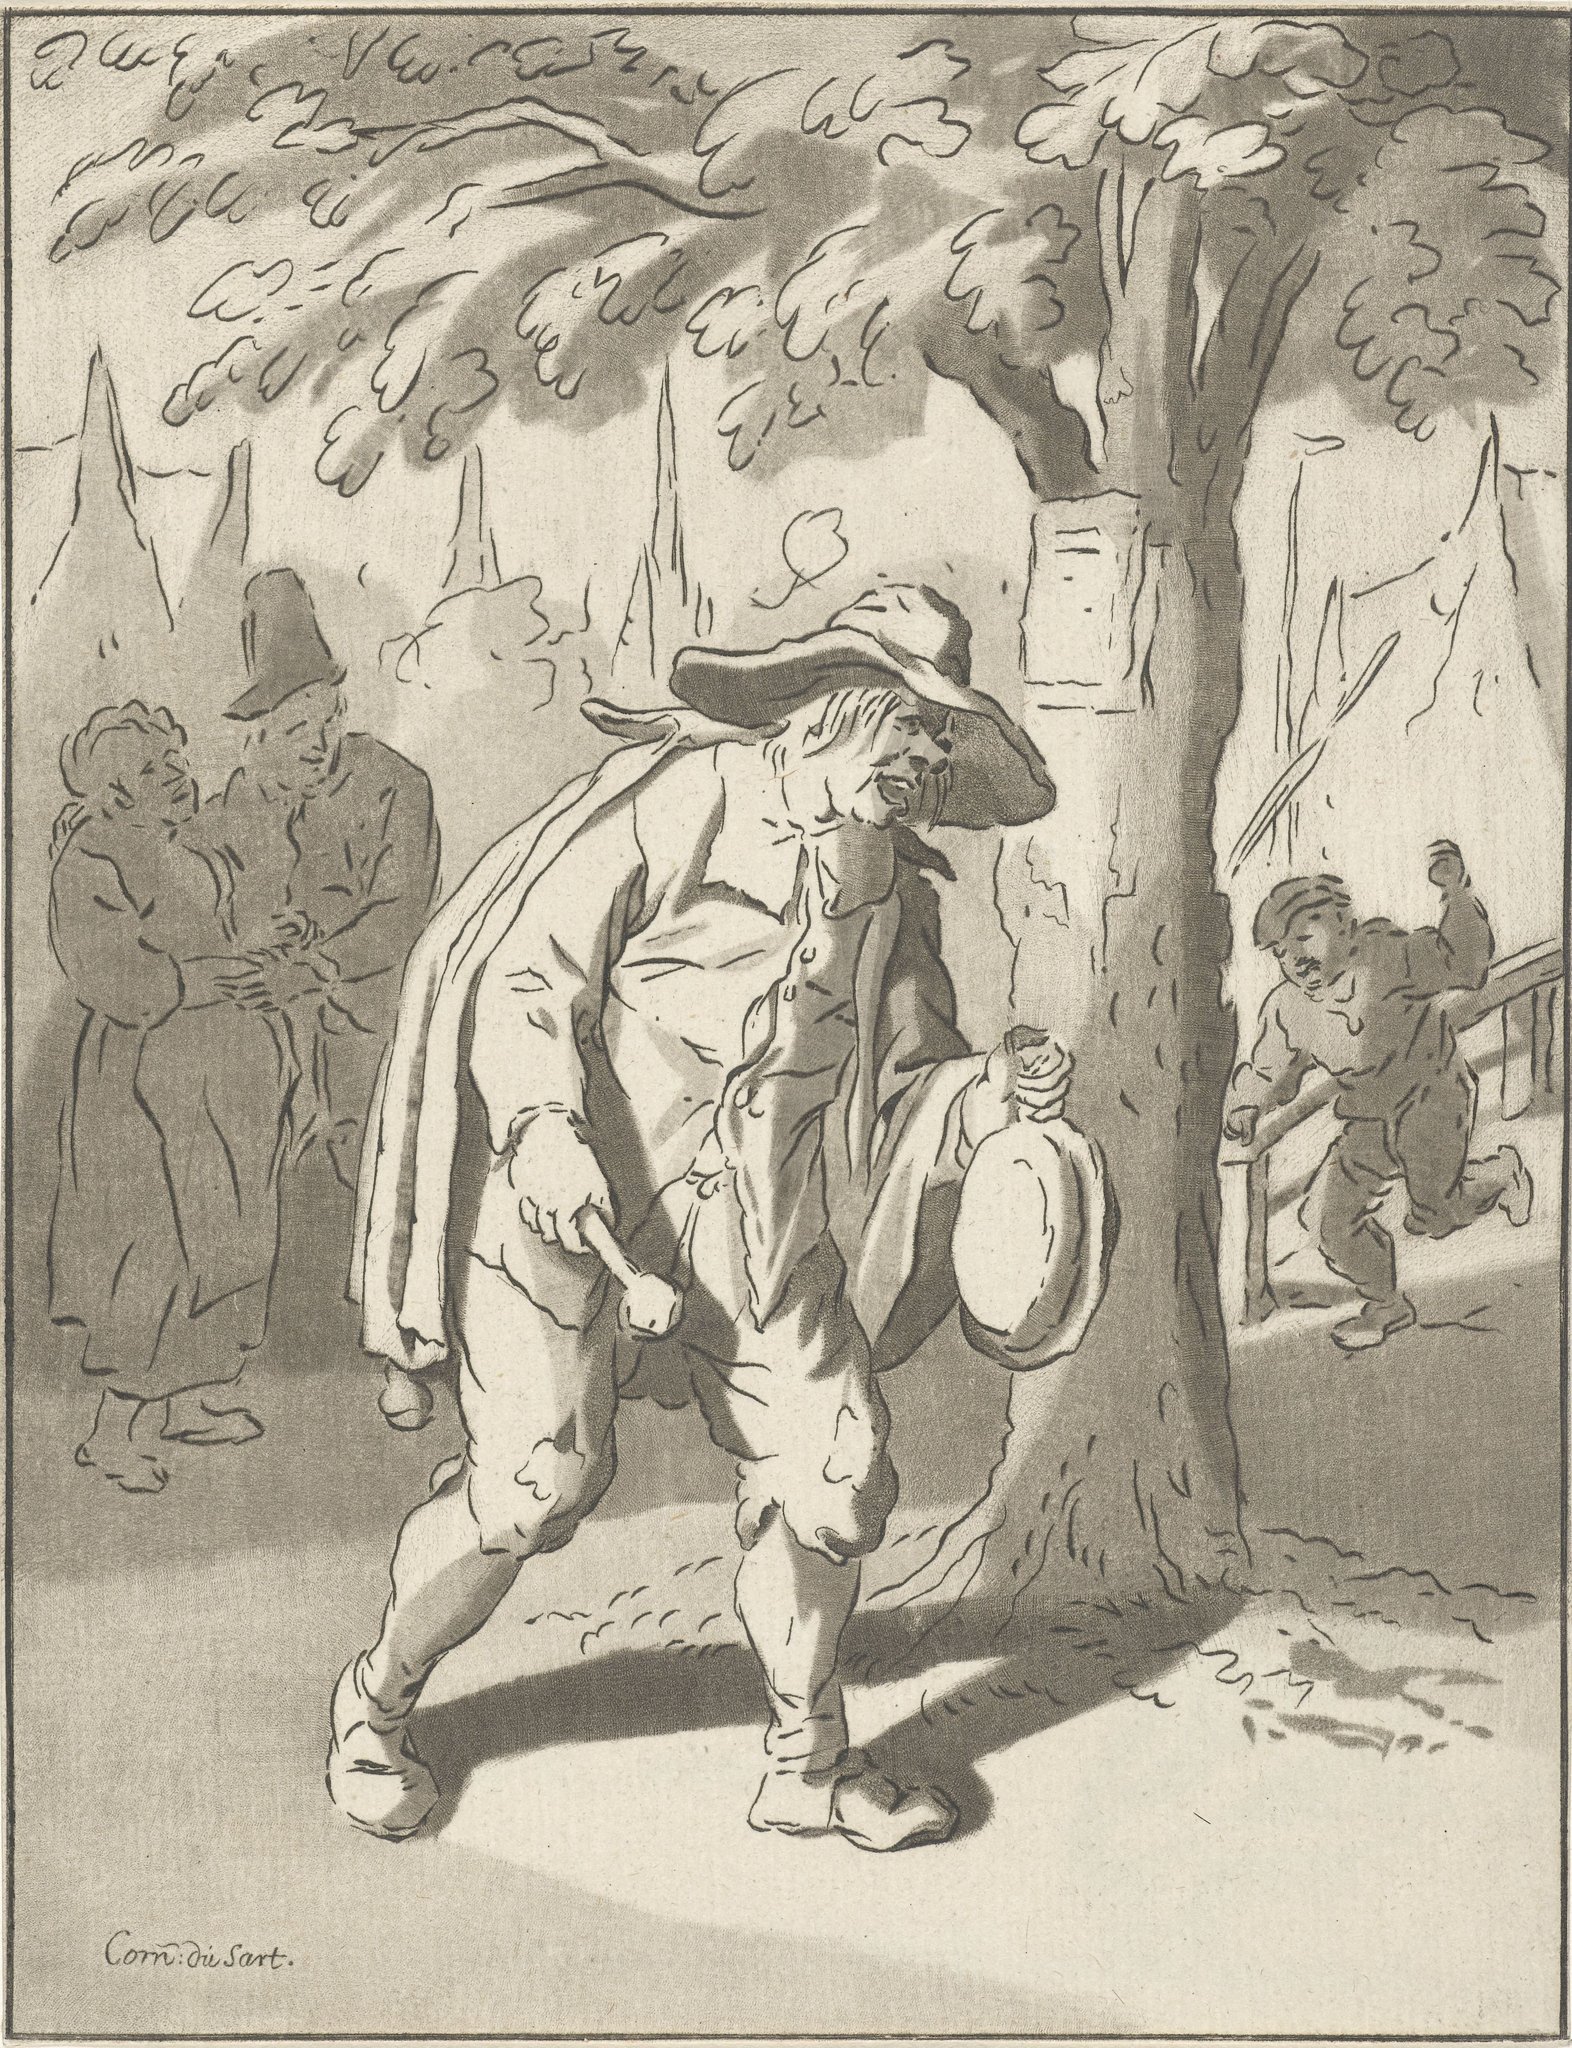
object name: print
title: Omroeper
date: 1776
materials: paper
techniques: etching, roulette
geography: amsterdam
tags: oral spreading of news, town crier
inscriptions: collector's mark: Lugt 240, inscription: ‘Corn. Dusart. del. Ploos v. Amstel. J.C. Fecit. 1776.’, collector's mark: Lugt 2725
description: Een stadsomroeper met slagwerk bij een boom. Op de achtergrond luisterende mensen.